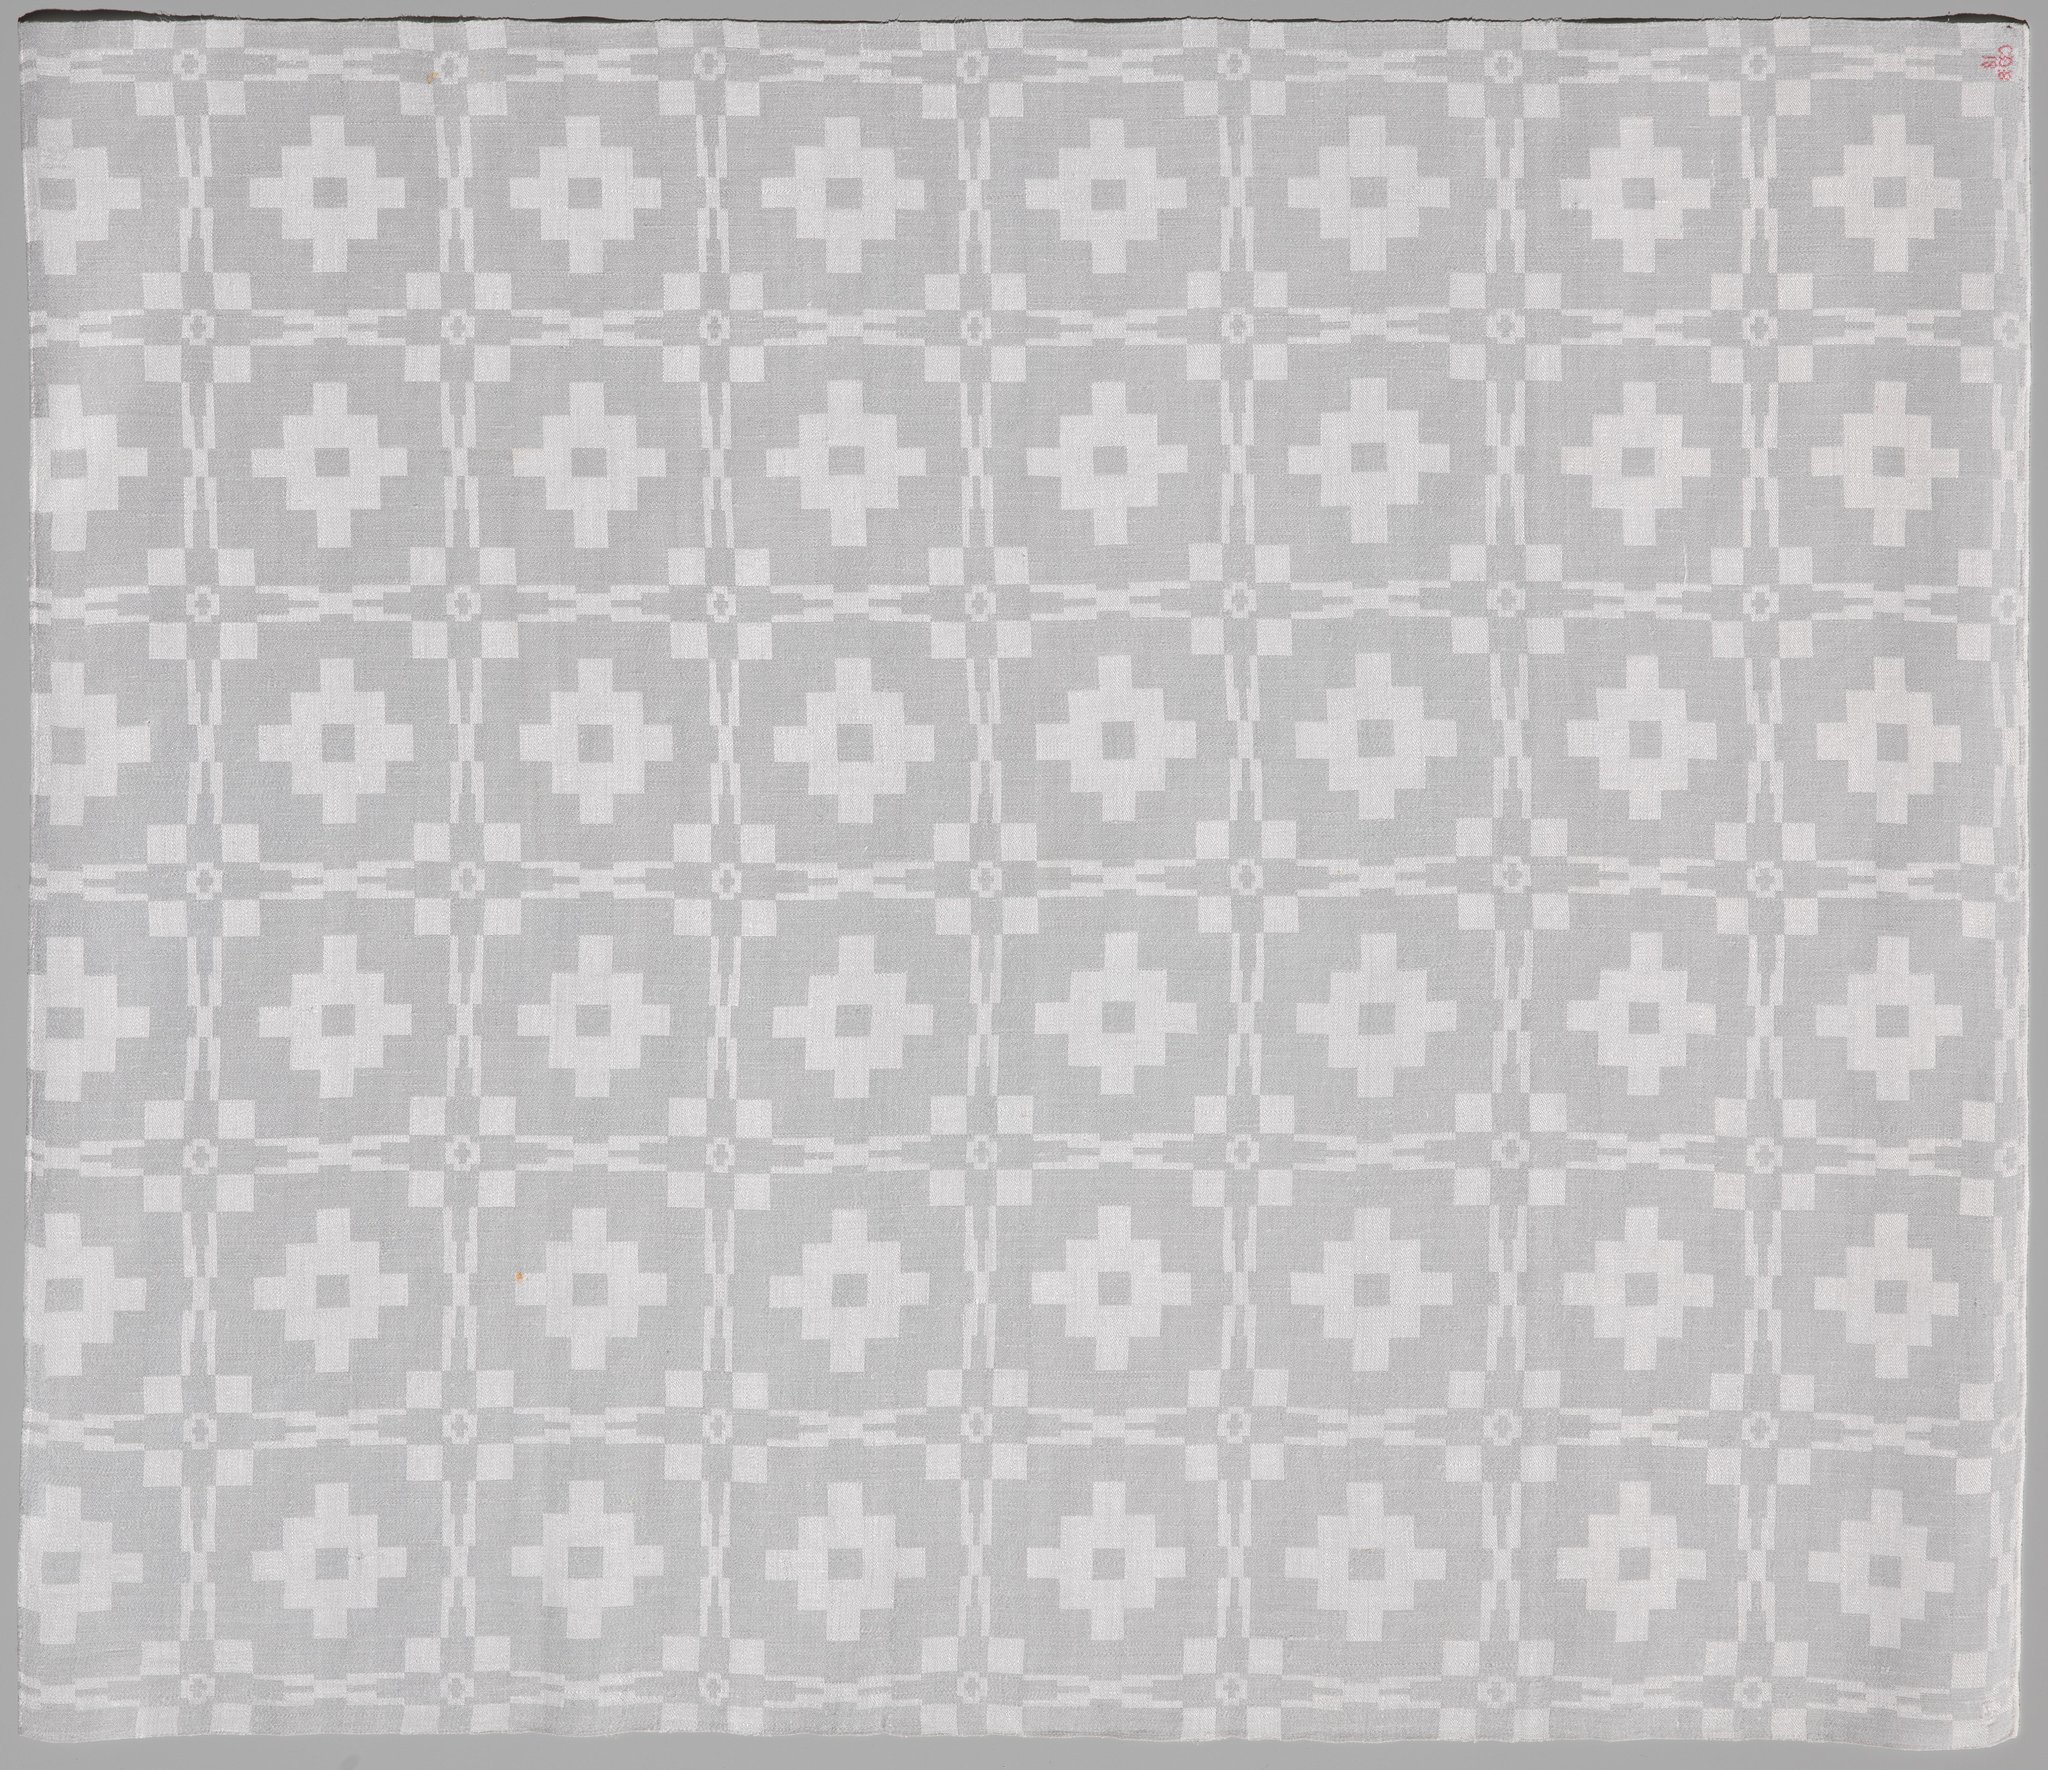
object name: napkin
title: Servet van pellendamast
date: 1700-1800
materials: linen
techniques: weave